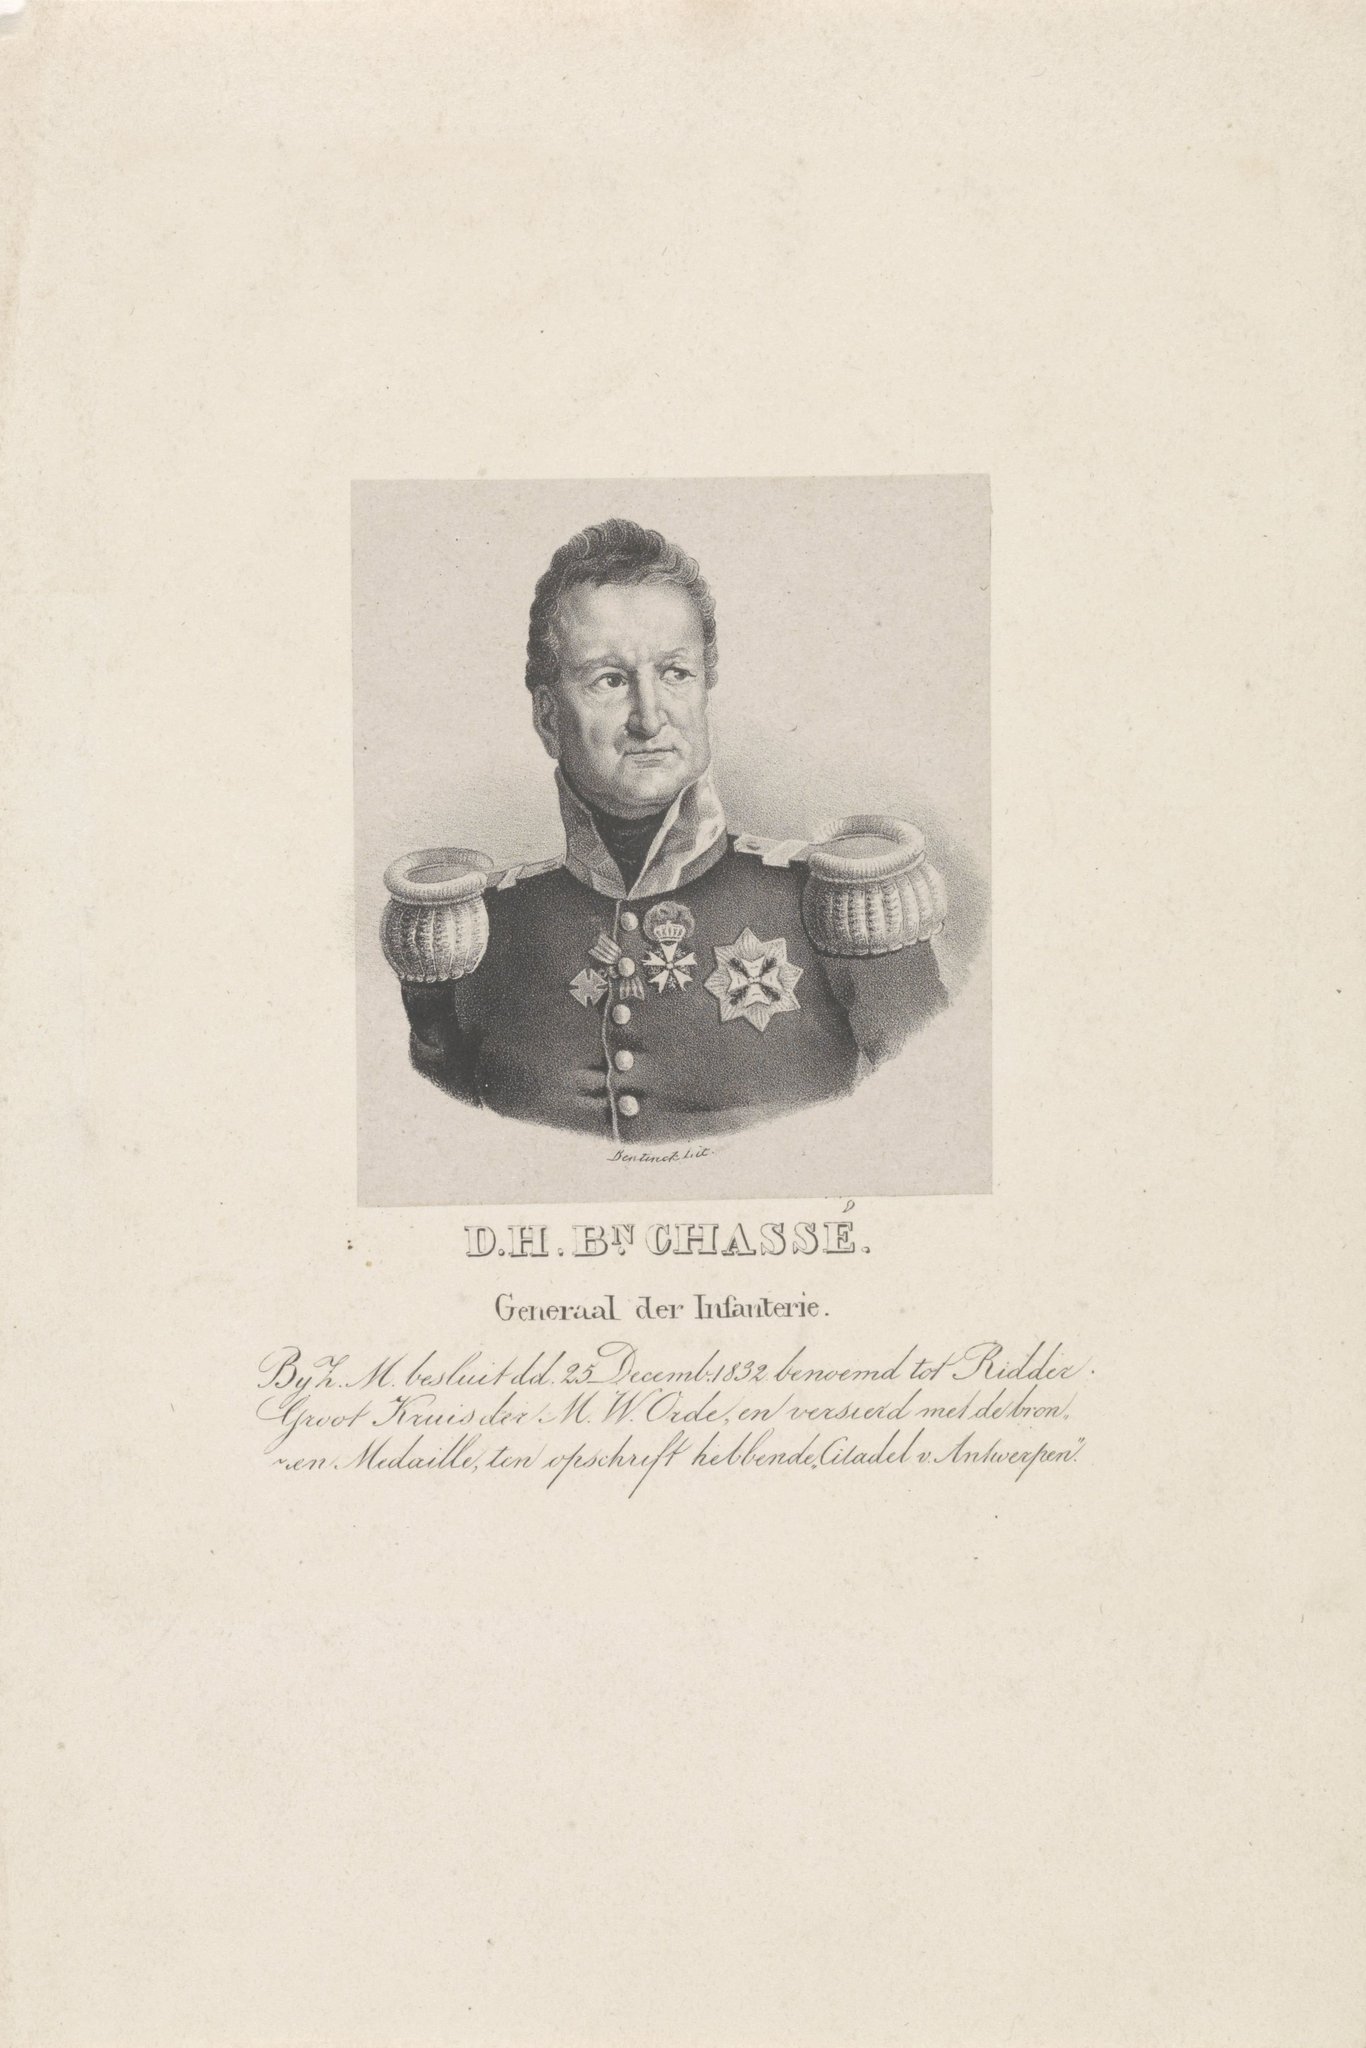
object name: print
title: Portret van generaal David Hendrik Chassé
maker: carel frederik curtenius bentinck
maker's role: print maker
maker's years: 1814-1849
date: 1824-1849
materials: paper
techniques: lithograph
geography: netherlands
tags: knighthood order, historical persons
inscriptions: collector's mark: Lugt 2228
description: De geportretteerde draagt een militair uniform met decoraties op de borst, epauletten en een opstaande kraag. Onder het portret zijn naam en beroep. Daaronder drie regels gewijd aan zijn onderscheidingen.